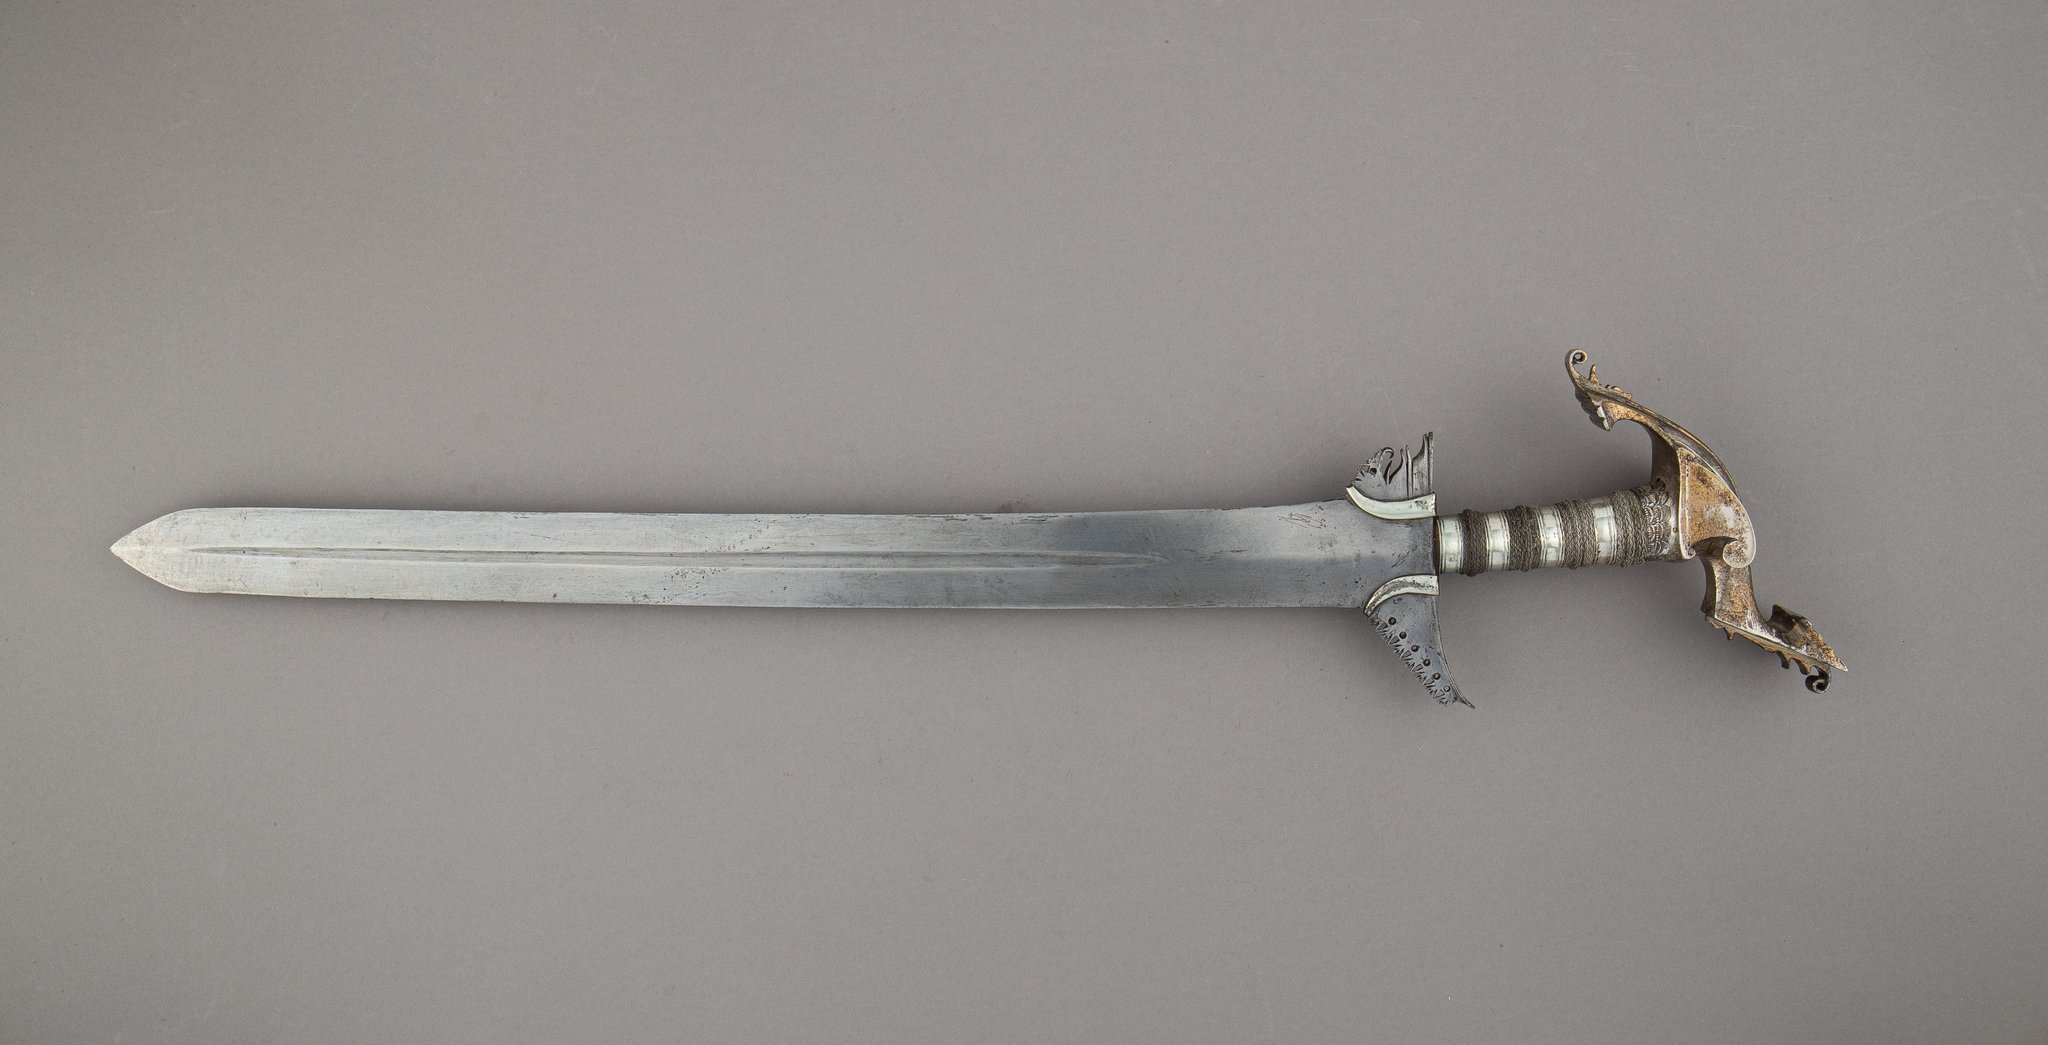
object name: kris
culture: philippine, jolo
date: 1701-1900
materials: silver, steel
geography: philippines